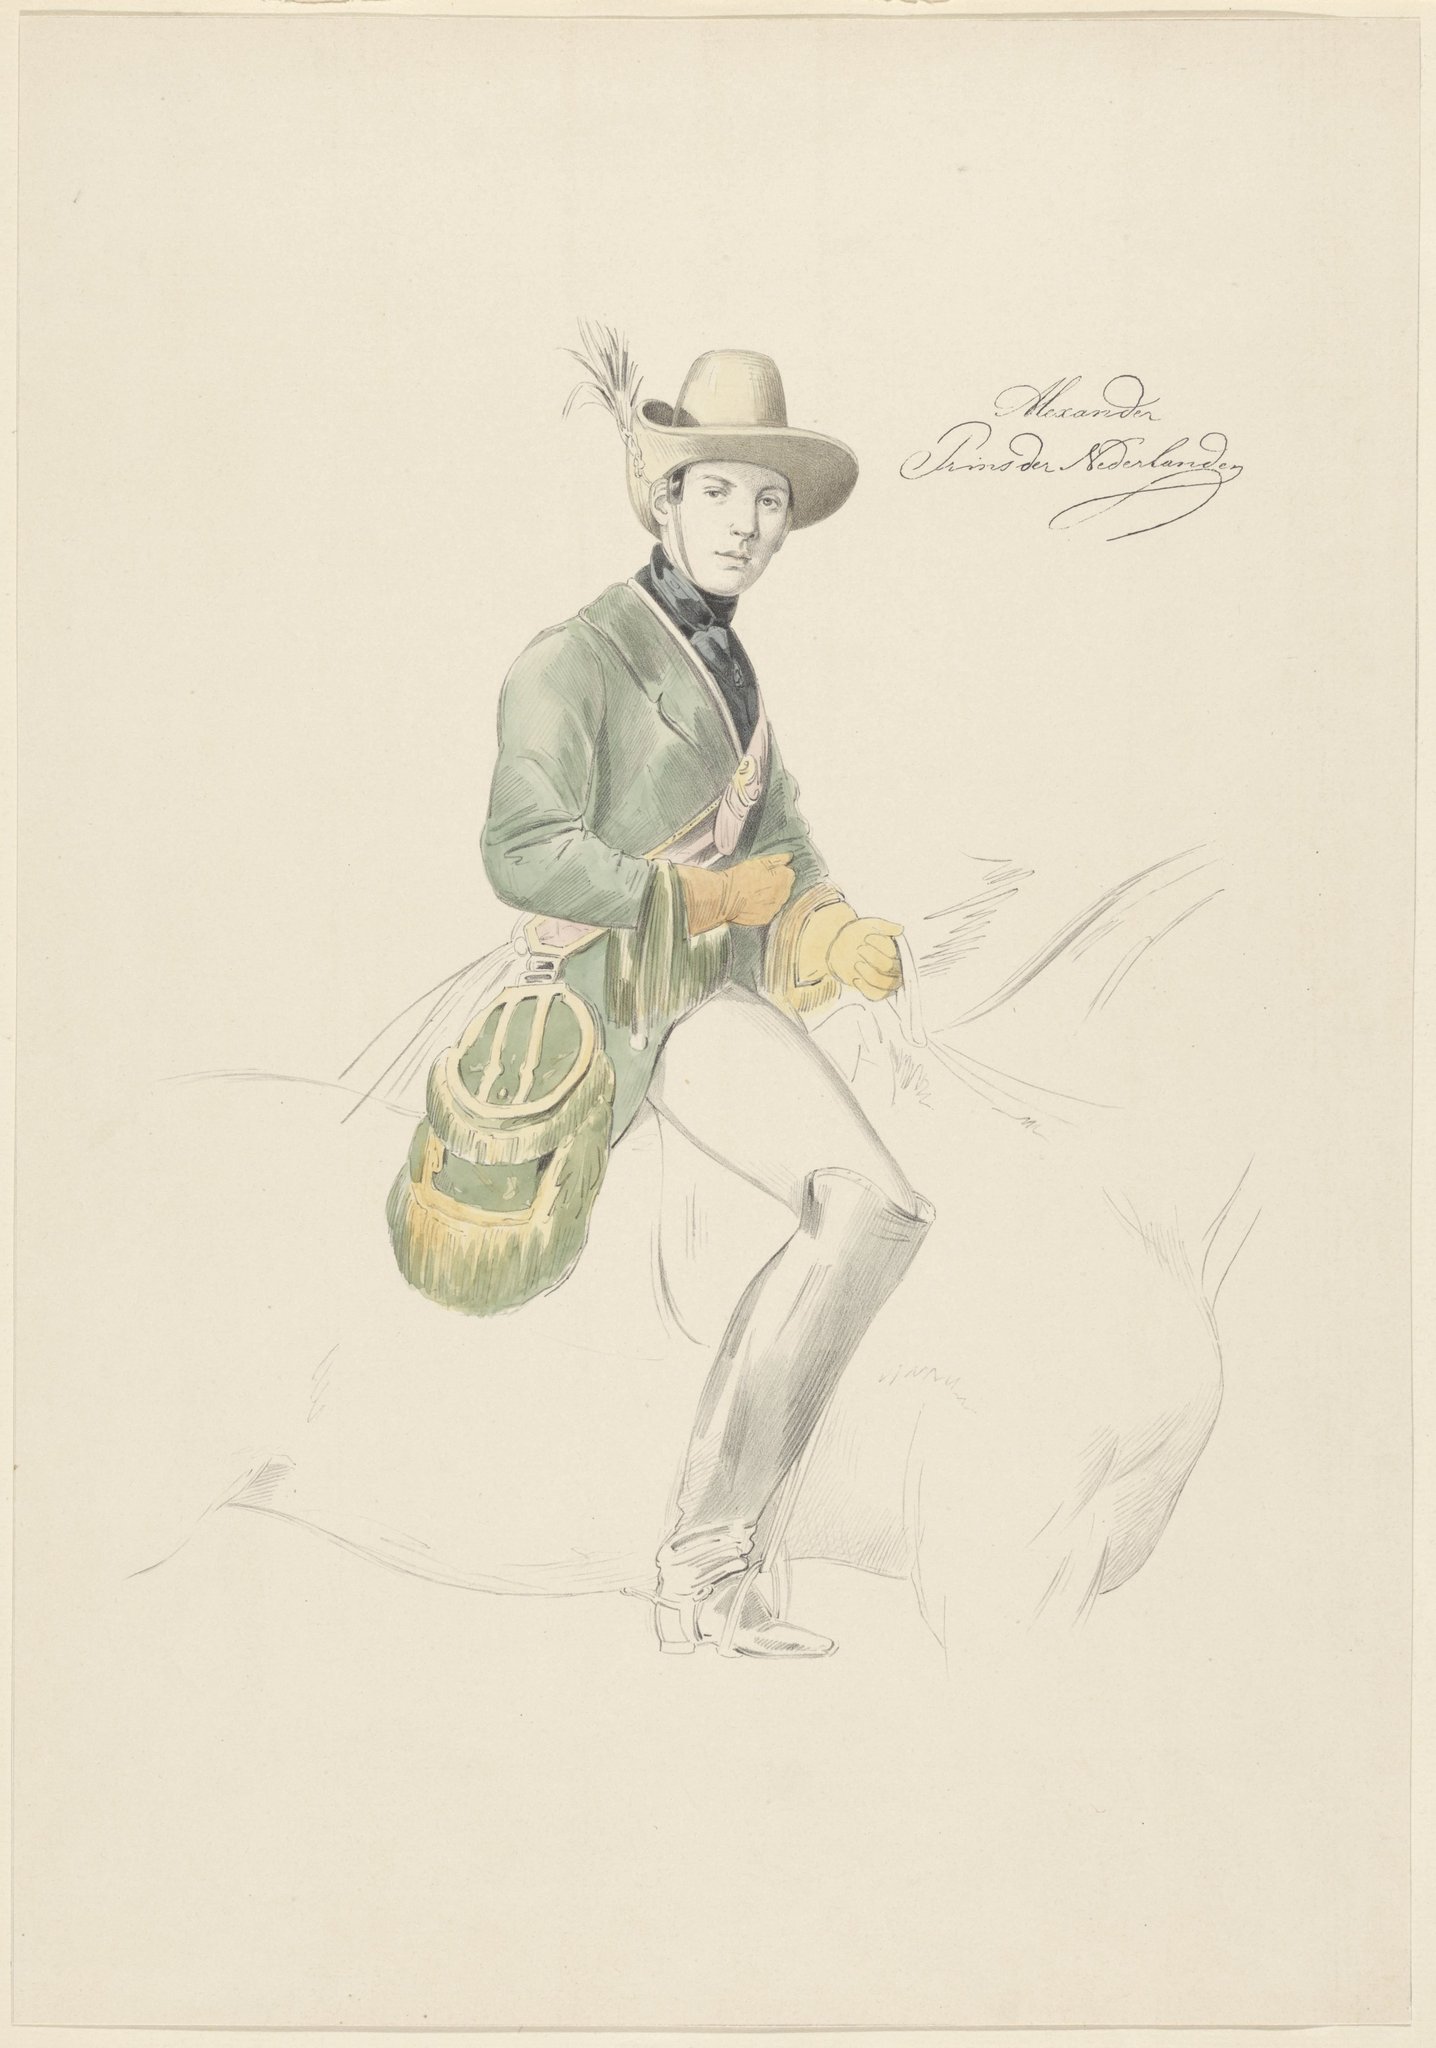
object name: print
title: Ruiterportret van Alexander I, prins der Nederlanden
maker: jonkheer willem daniël de vignon van alphen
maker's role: print maker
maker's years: 1815-1871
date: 1843-1871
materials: paper, watercolor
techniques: brush, lithograph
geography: netherlands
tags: alexander (prins der nederlanden, prins van oranje-nassau), equestrian state-portrait, bird hunting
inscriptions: collector's mark: Lugt 2228, collector's mark: Lugt 2760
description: Naar het schilderij door Johann Baptist Wilhelm Adolf Sonderland, Groepsportret van leden van The Royal Loo Hawking Club, 1843 gedateerd; Den Haag, Stichting Historische Verzamelingen van het Huis Oranje-Nassau.